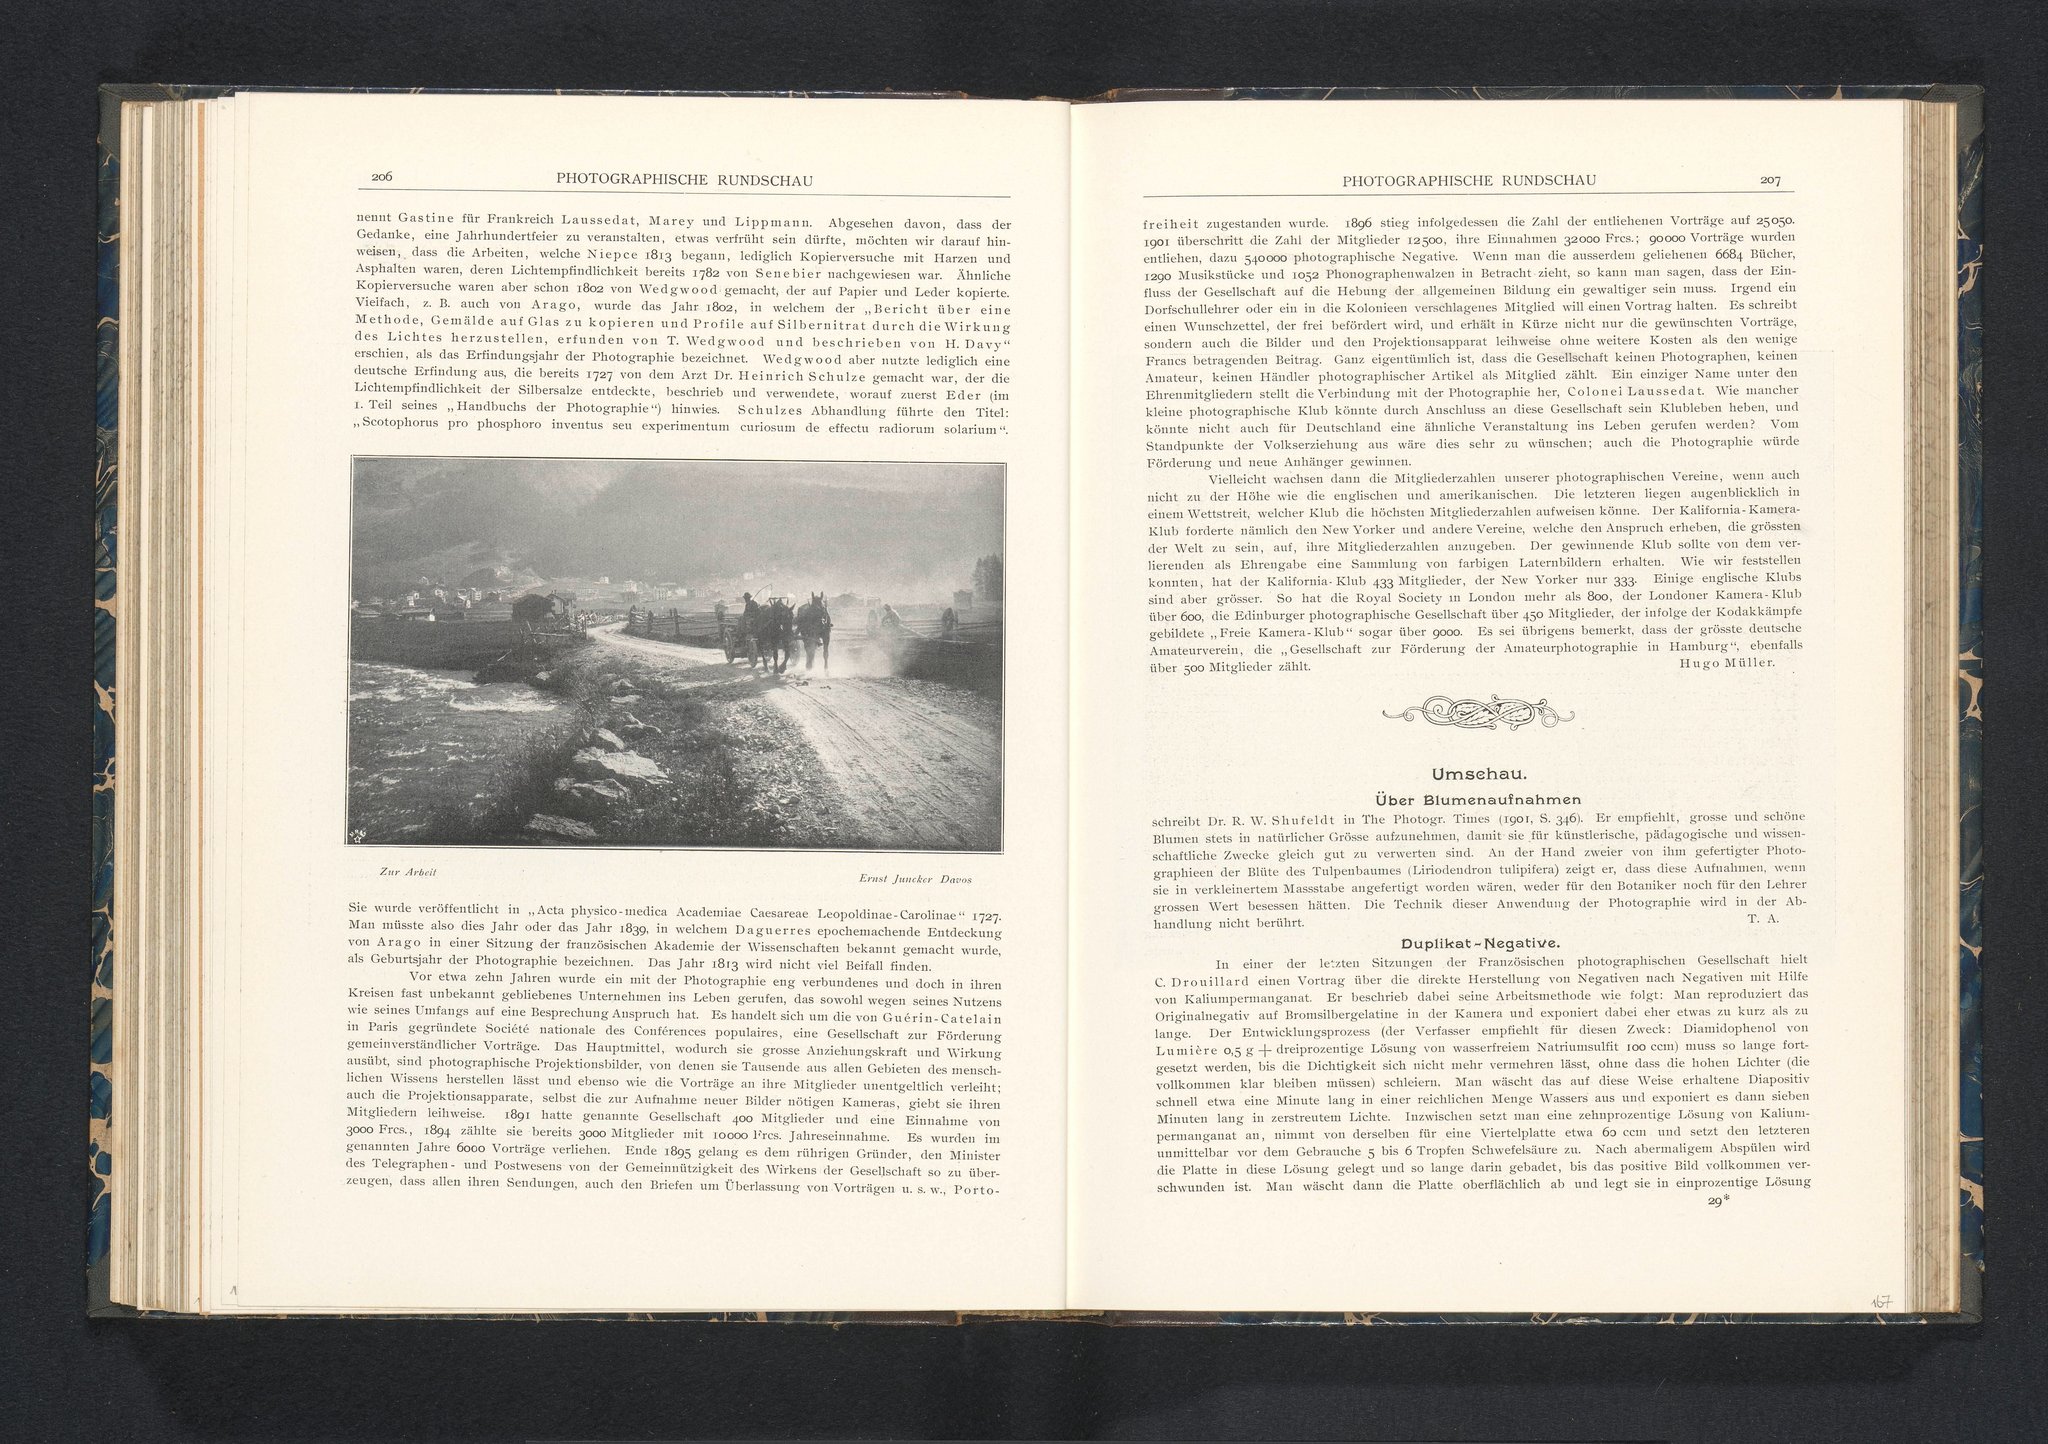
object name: page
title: Wagen met twee paarden ervoor op een landweg grenzend aan water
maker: e. juncker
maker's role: fotograaf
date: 1896-1901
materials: paper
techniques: autotype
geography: berlin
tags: four-wheeled, animal-drawn vehicle, e.g.: cab, carriage, coach, road, path, horse